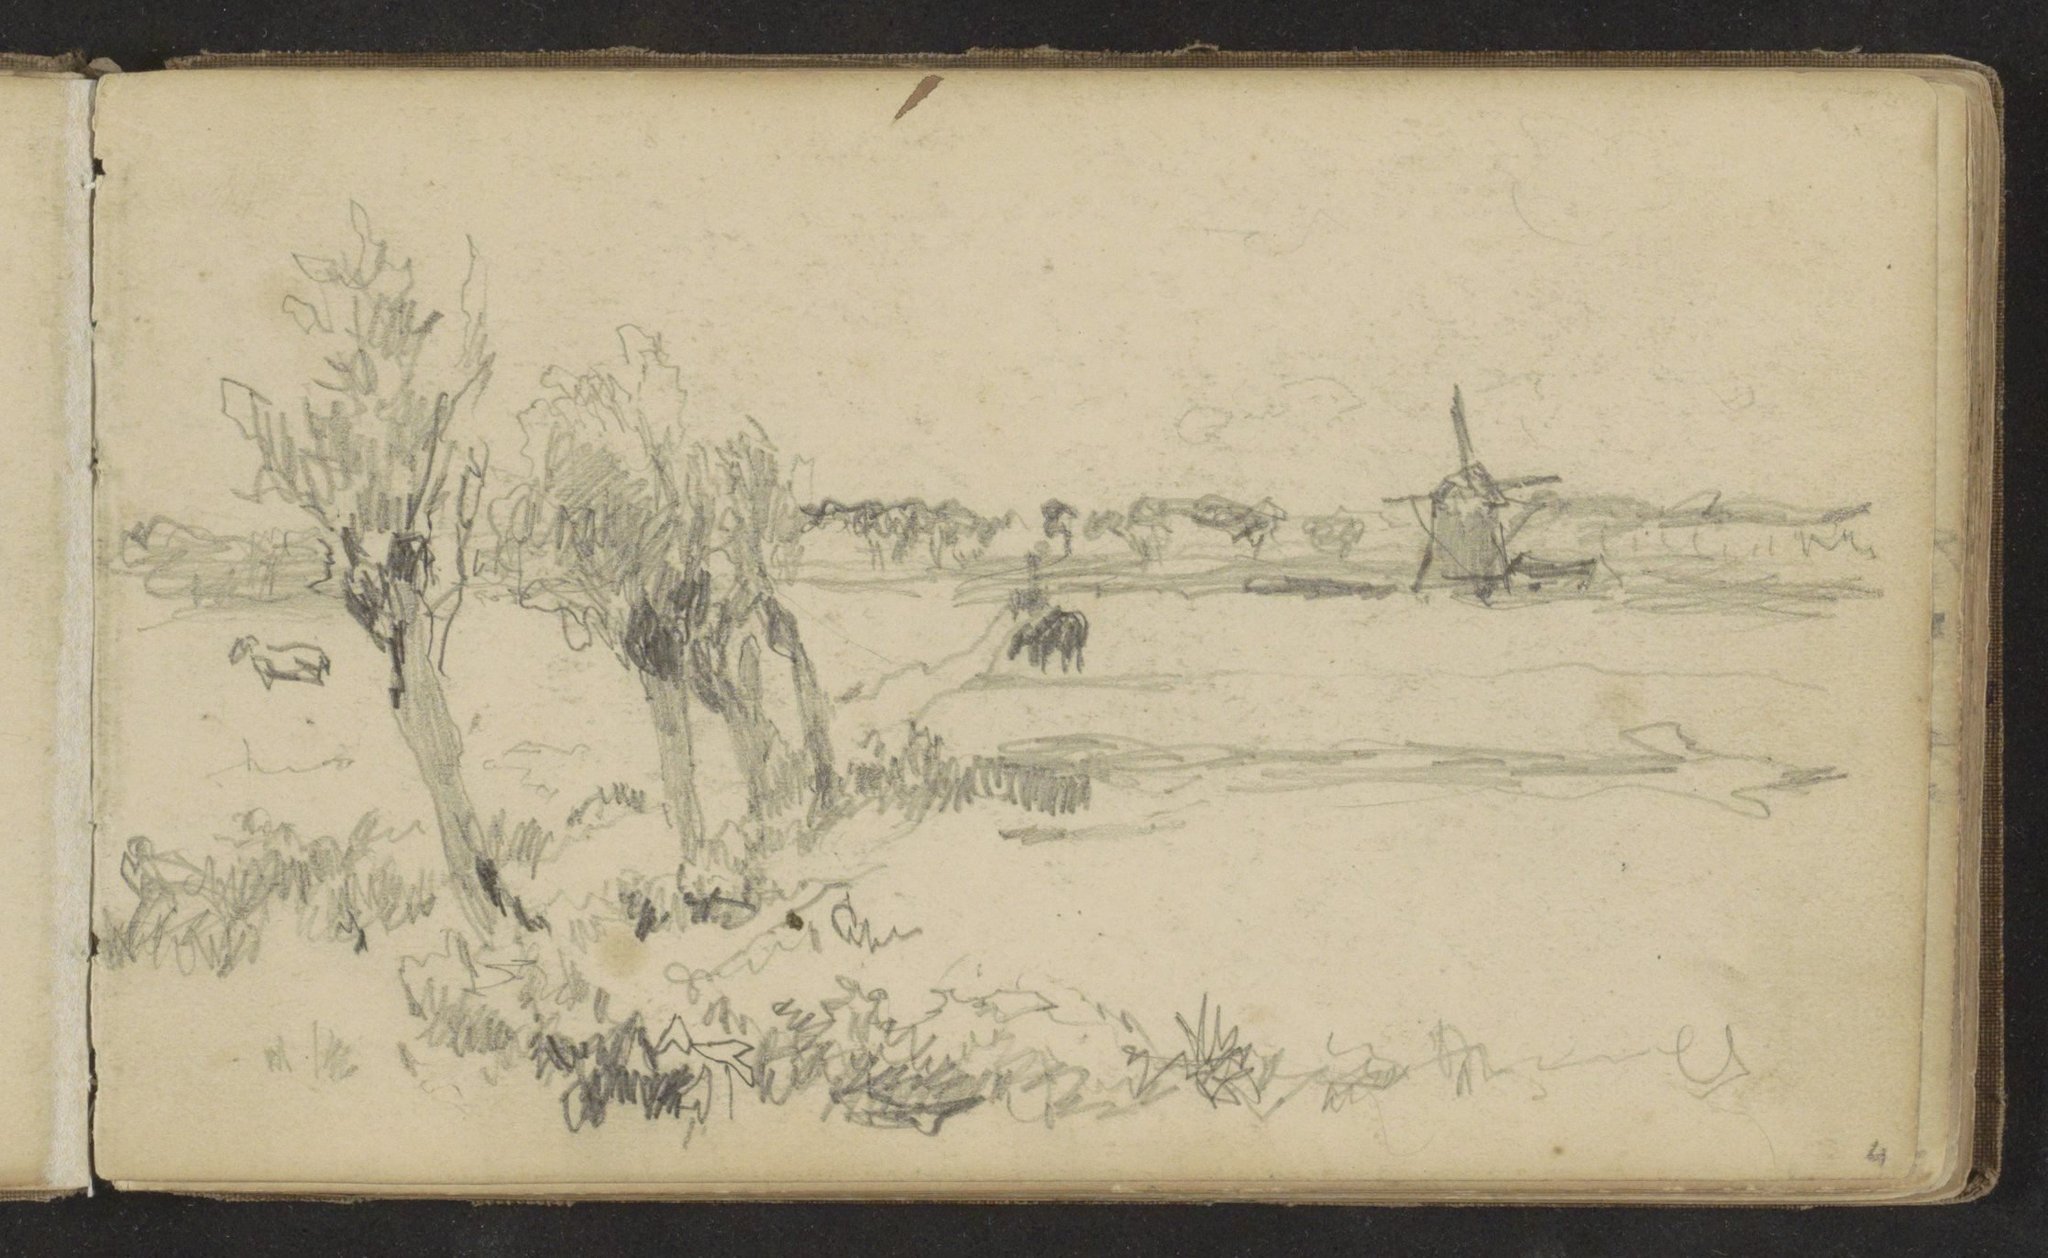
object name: sketchbook leaf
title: Landschap met bomen en een molen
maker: johan hendrik weissenbruch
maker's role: draughtsman, painter, print maker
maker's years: 1824-1903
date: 1834-1903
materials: paper, pencil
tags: windmill in landscape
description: Blad 4 recto uit een schetsboek met 43 bladen.